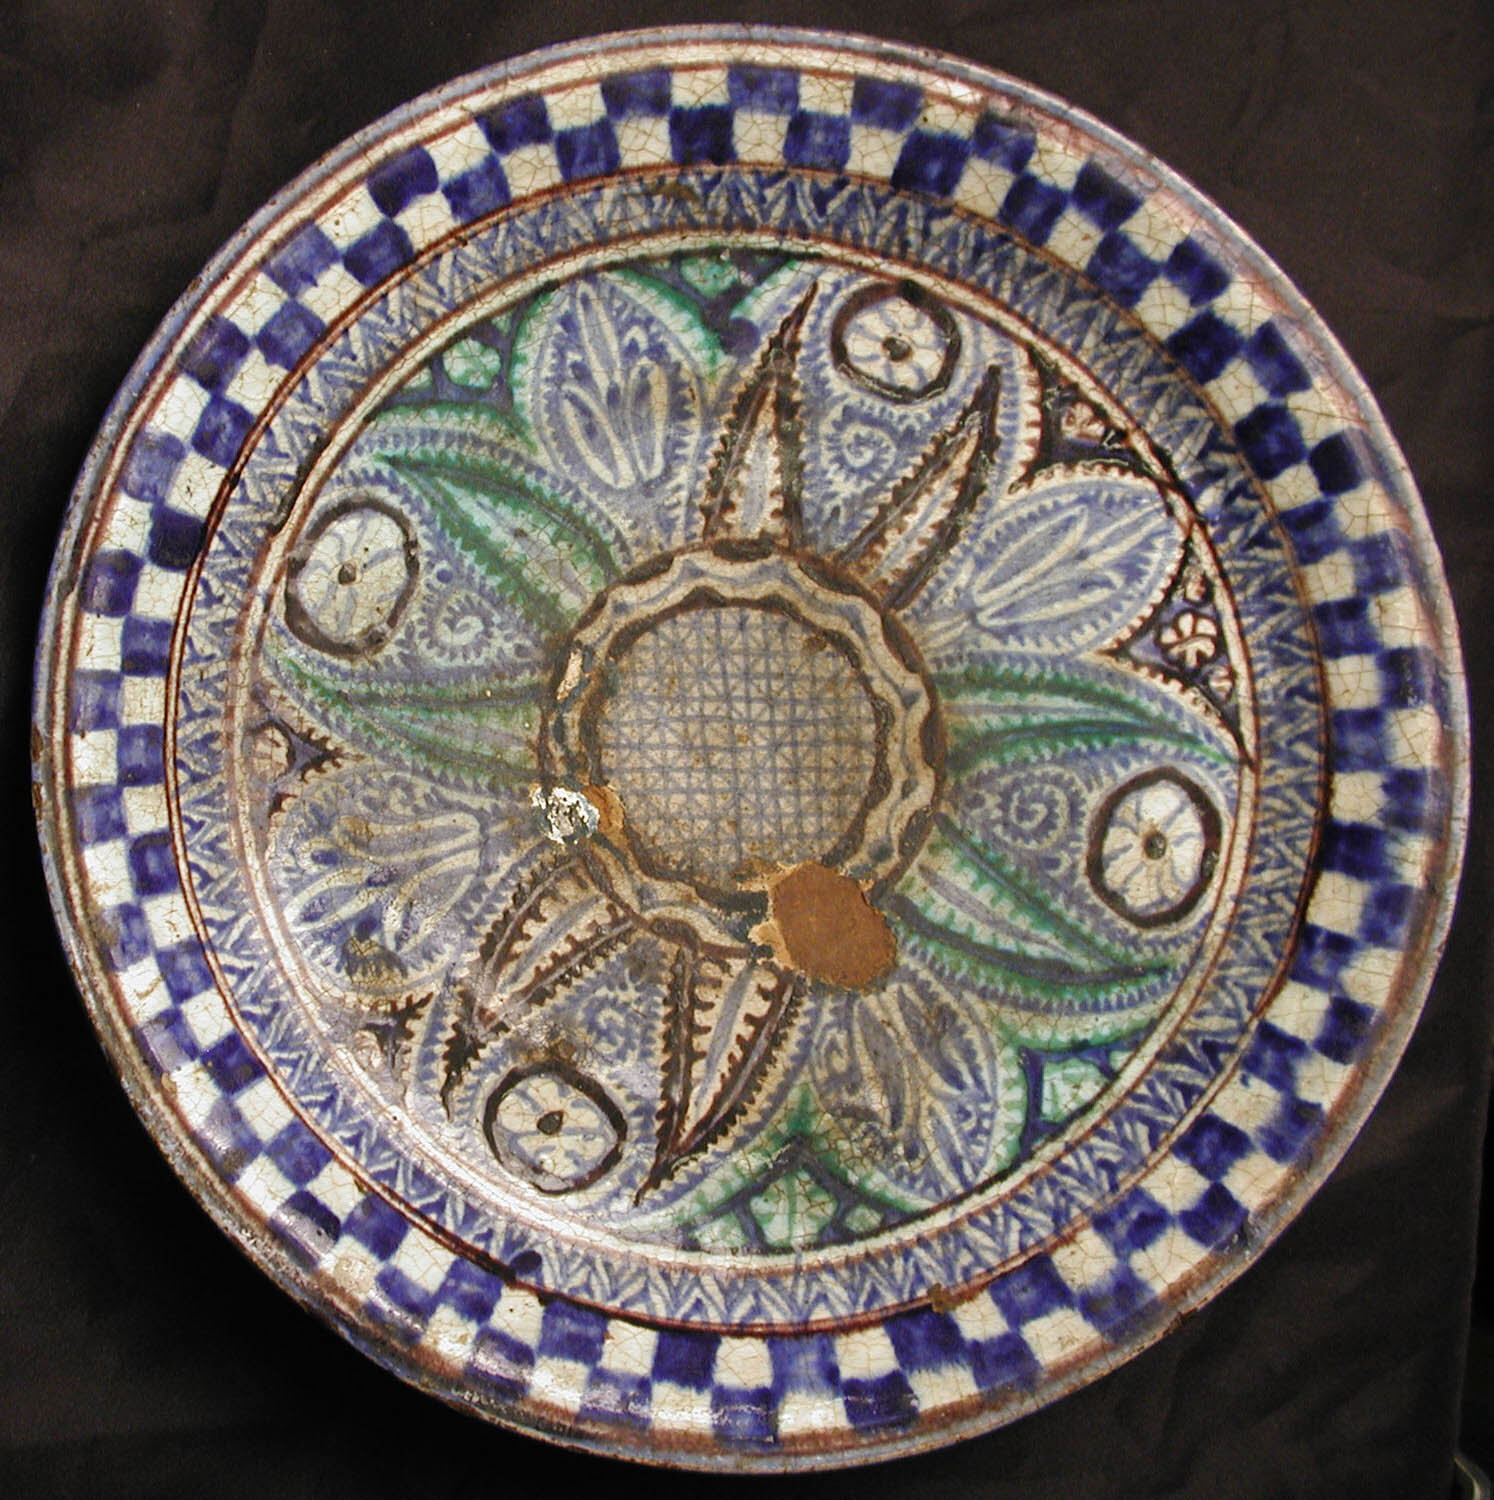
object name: bowl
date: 1701-1900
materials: earthenware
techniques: painting, polychrome, underglaze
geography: uzbekistan